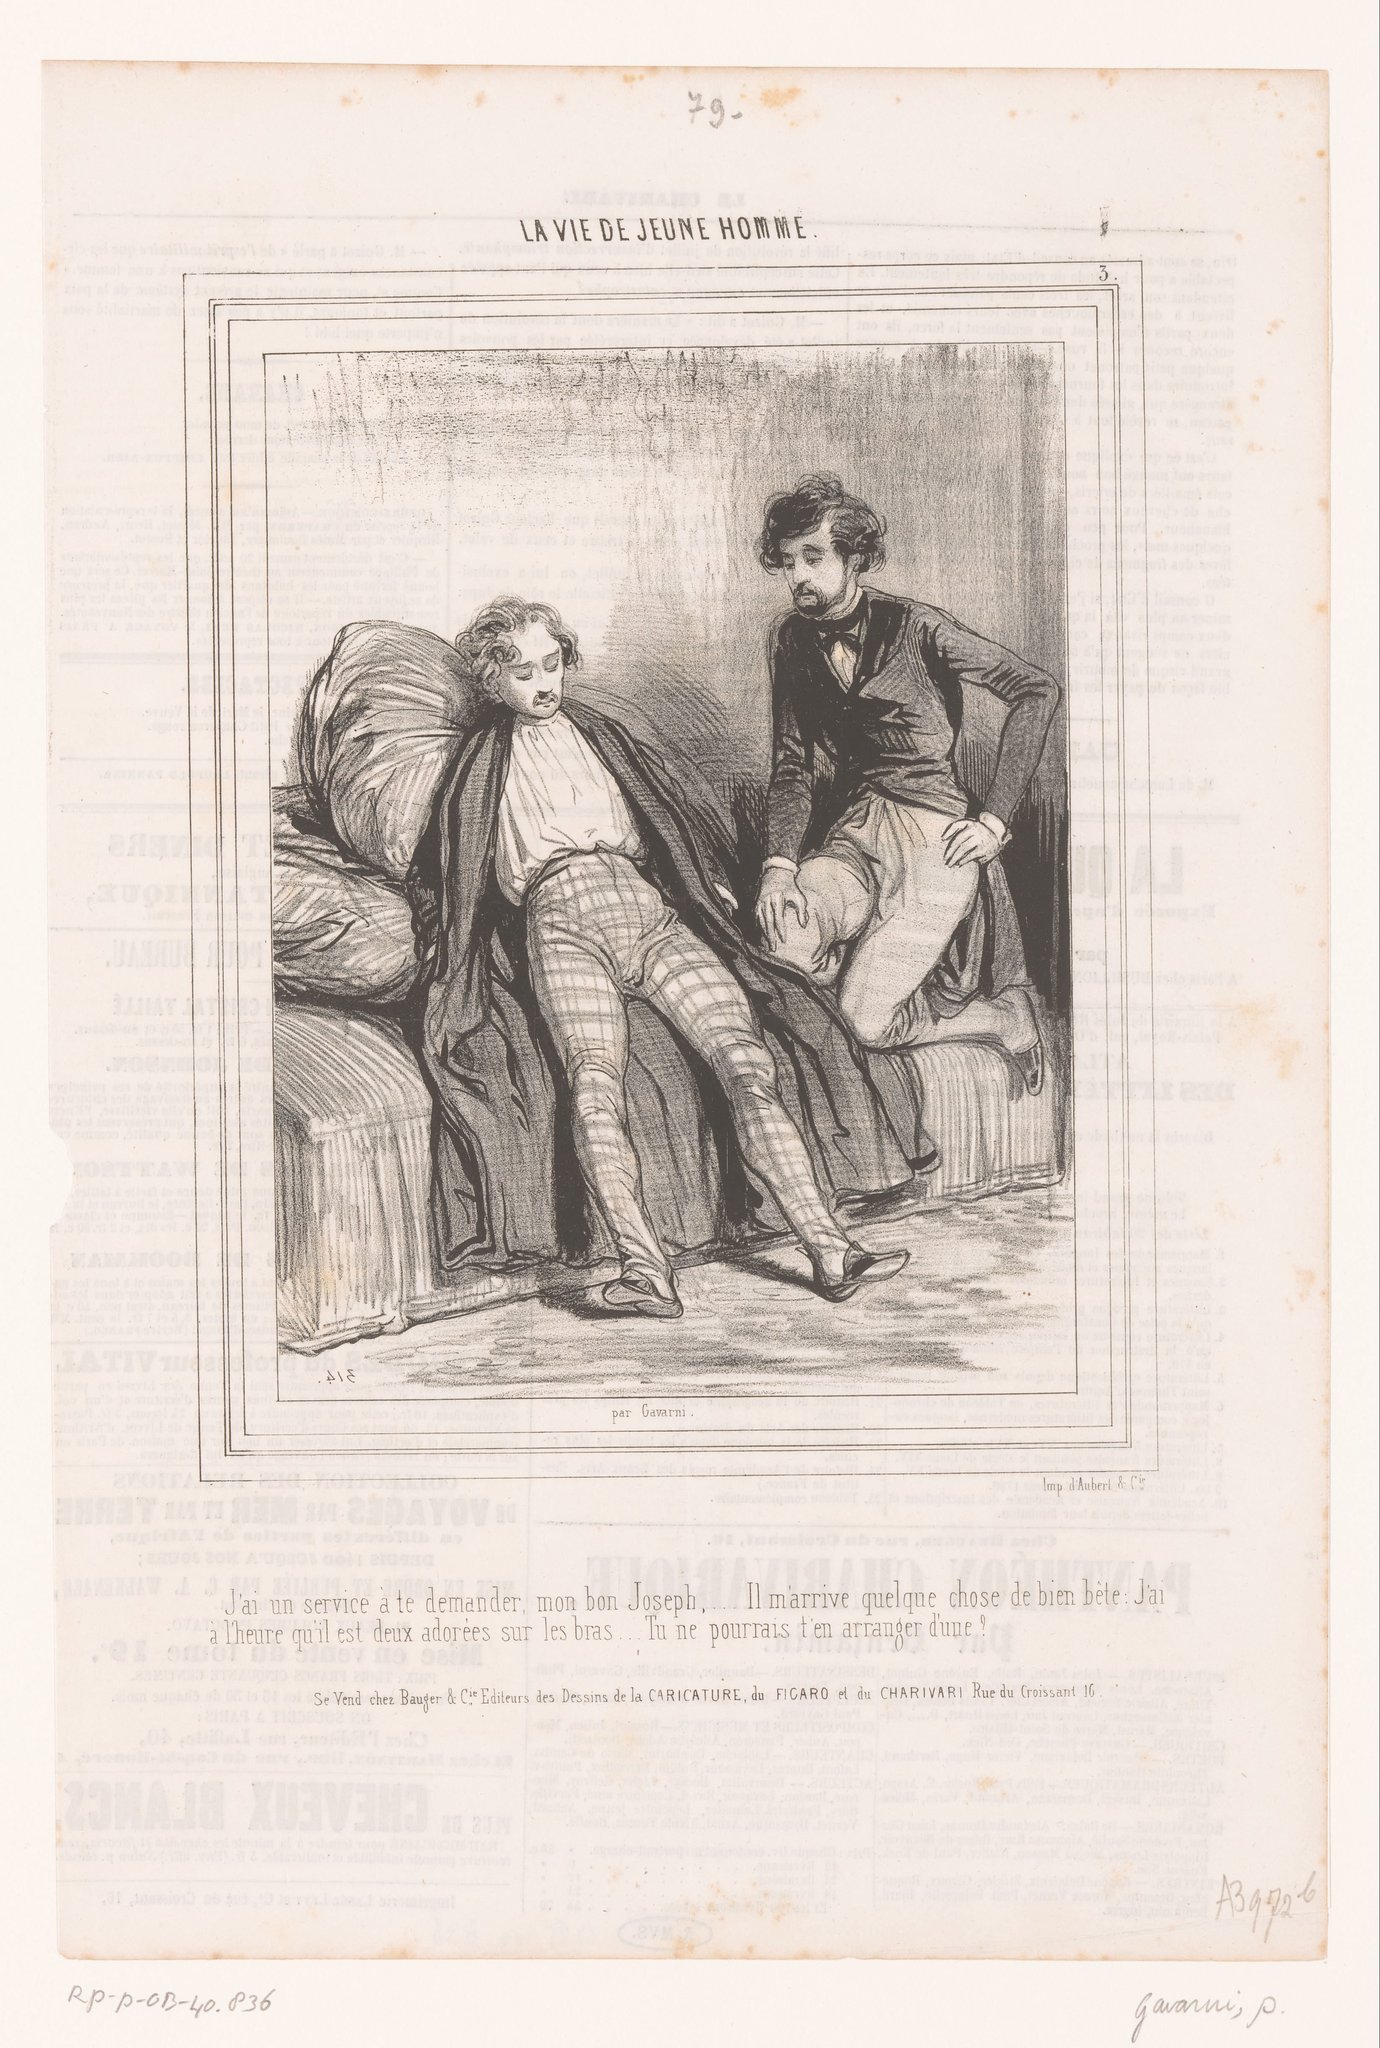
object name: cartoon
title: J'ai un sevice à te demander, mon bon Joseph (...)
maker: paul gavarni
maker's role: draughtsman, print maker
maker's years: 1804-1866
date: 1842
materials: paper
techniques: lithograph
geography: paris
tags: student love, sitting on an elevation, couch, sofa, settee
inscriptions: collector's mark: Lugt 2228a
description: Prent gebruikt voor: La Caricature, 22 november 1840, en voor: Le Charivari, 20 augustus 1842.